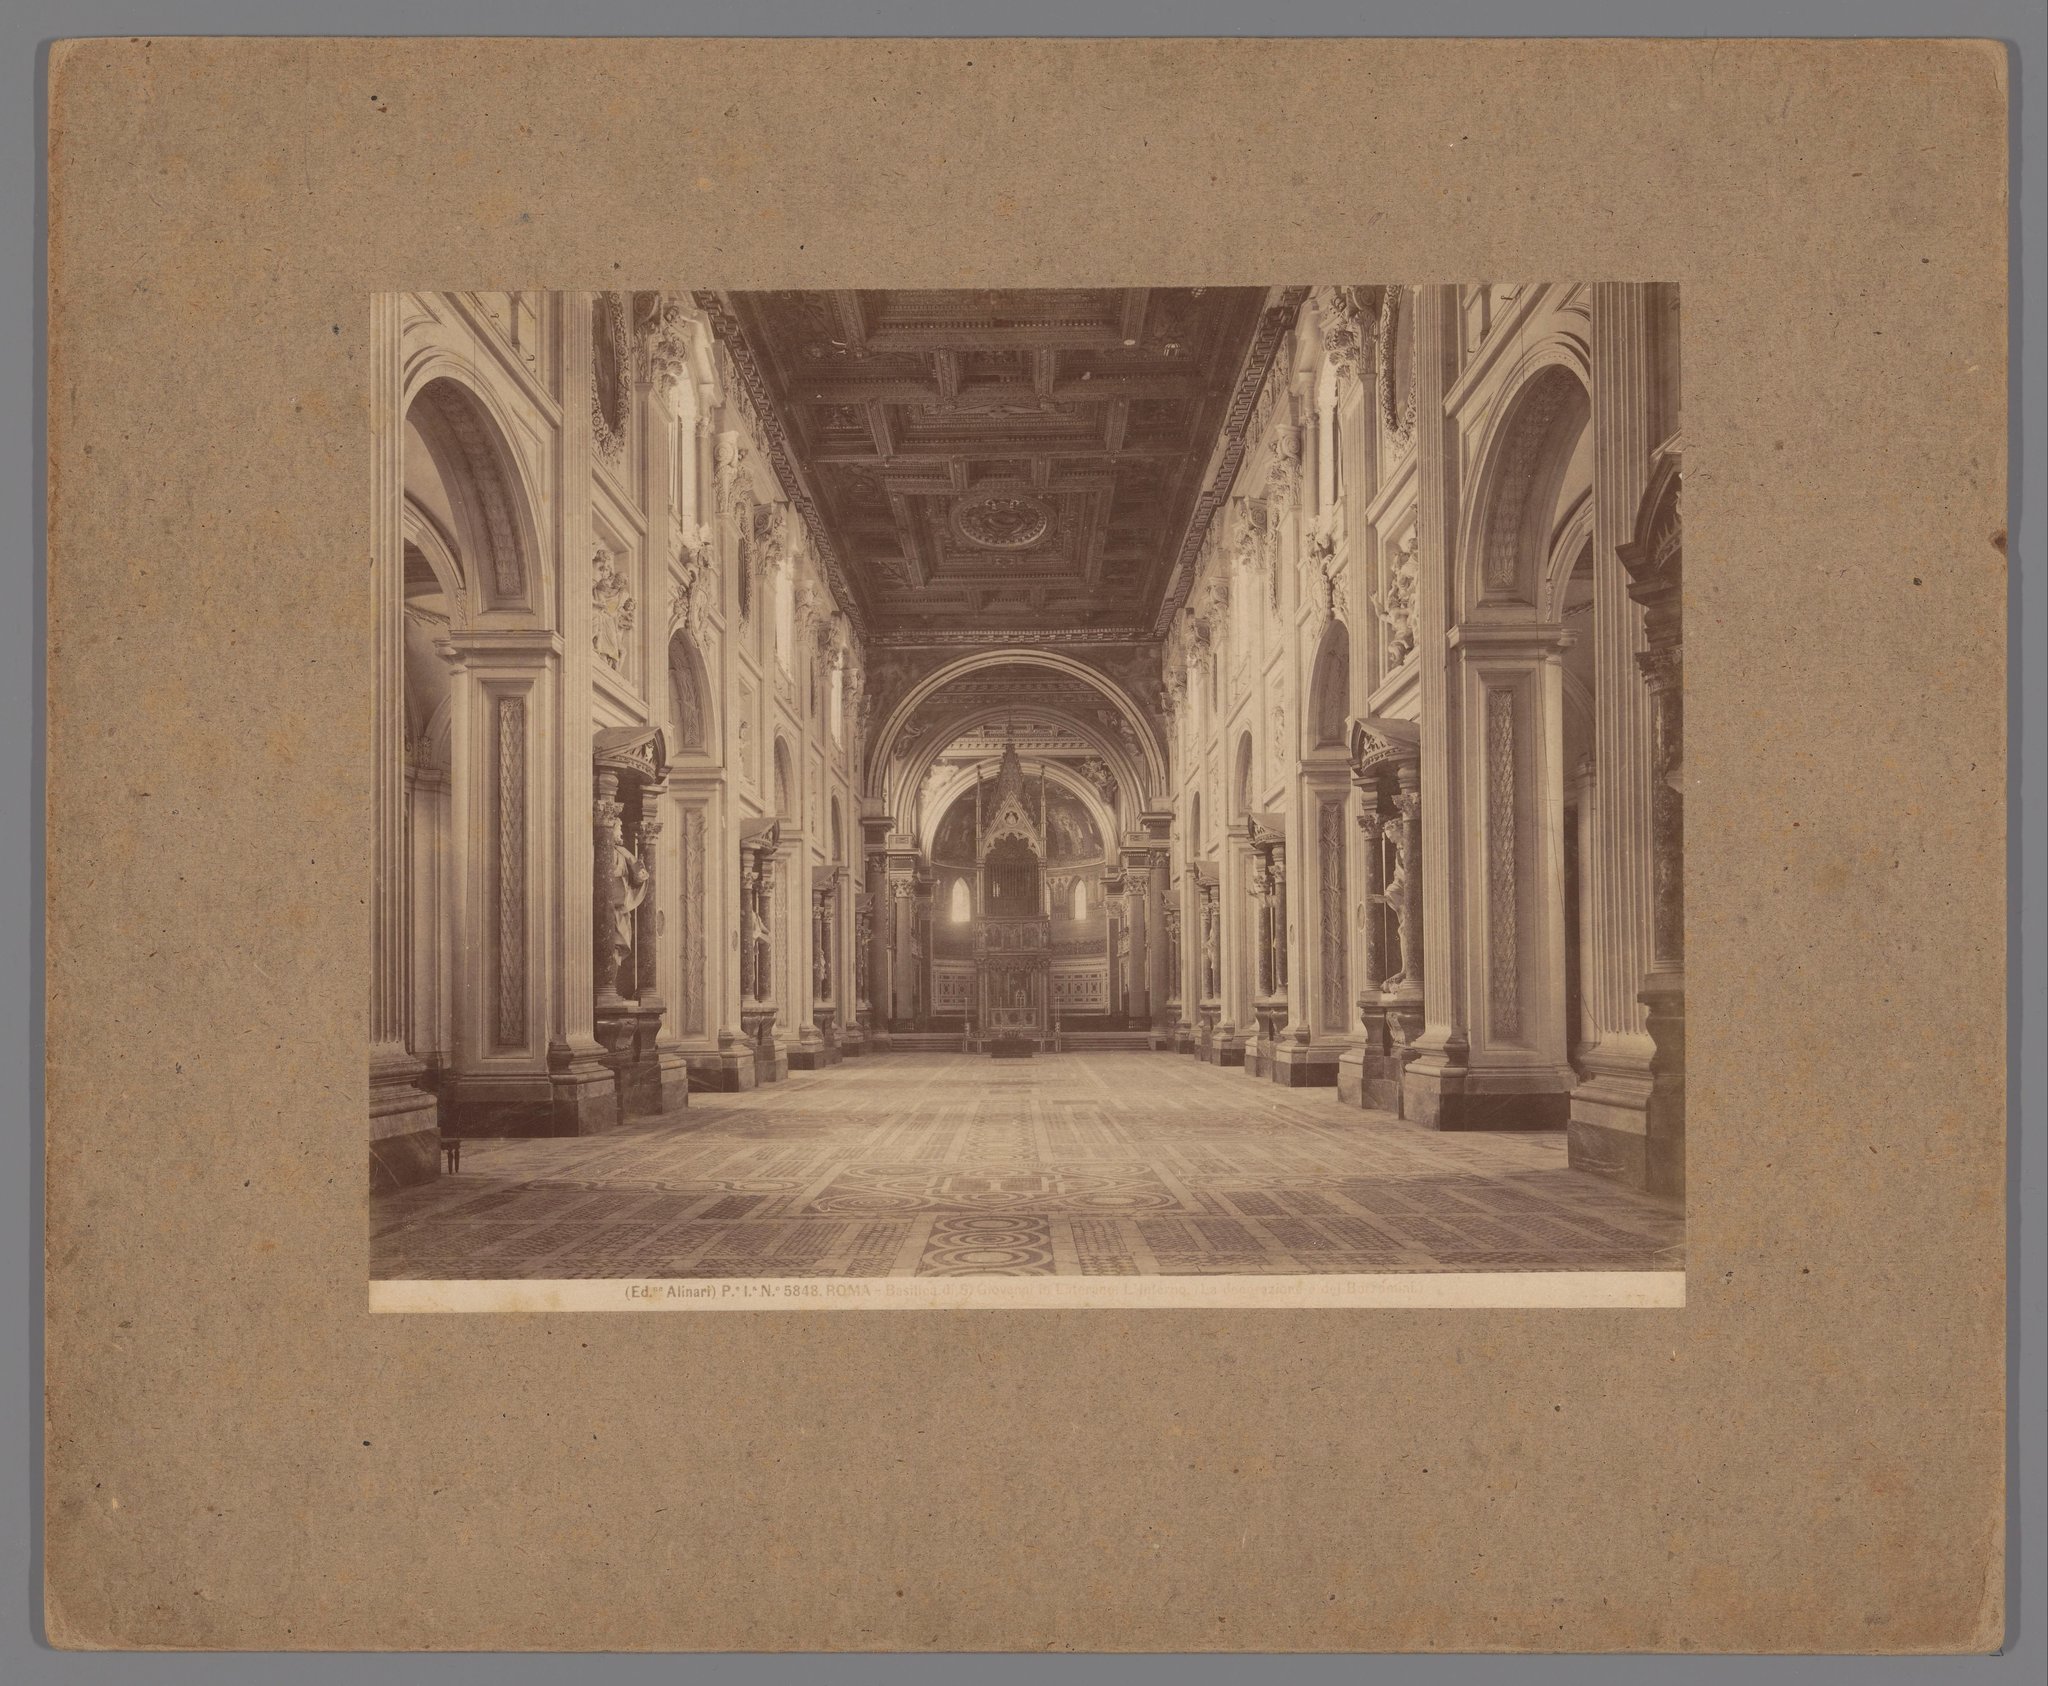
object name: photograph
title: ROMA - Basilica di S. Giovanni in Laterano. L'Interno.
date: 1875-1900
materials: cardboard, photographic support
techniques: albumen print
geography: sint-jan van lateranen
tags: parts of church interior: nave, parts of church interior: choir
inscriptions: number: ‘P.e I.a N.o 5848.’, collector's mark: Lugt 3937